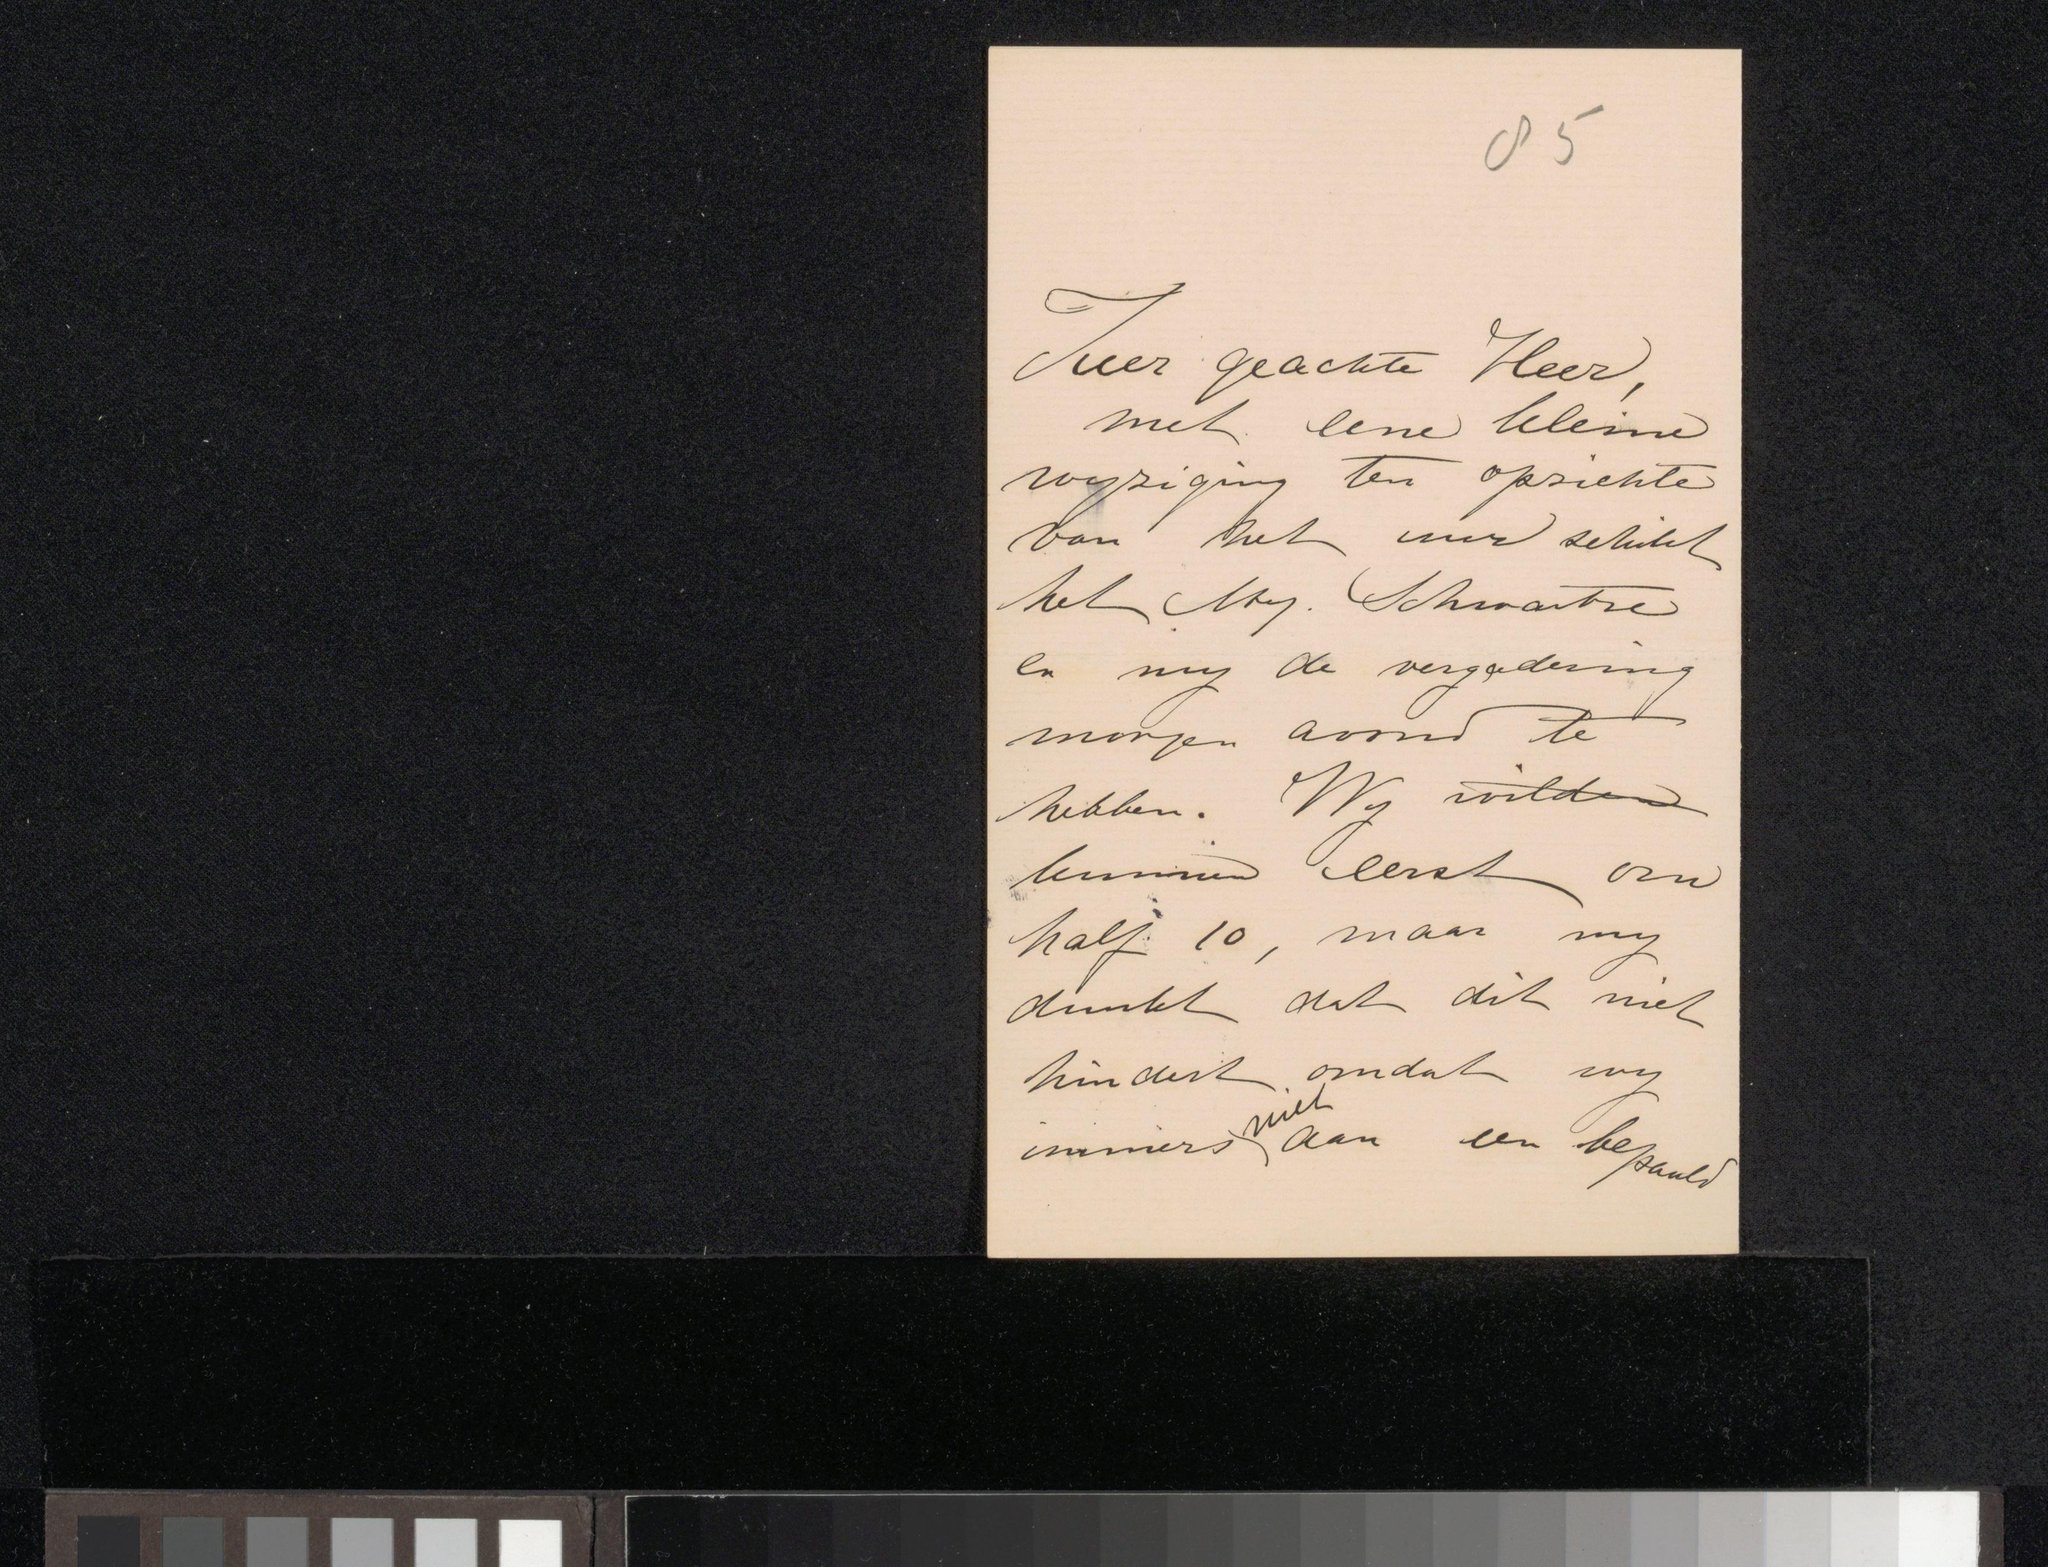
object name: letter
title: Brief aan Jan Veth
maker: wally moes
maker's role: draughtsman, print maker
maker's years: 1856-1918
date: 1874-1918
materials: ink, paper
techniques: pen, writing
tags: thérèse schwartze, dordrecht, painter, print maker, draughtsman, designer, jan veth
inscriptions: collector's mark: ‘RPK’